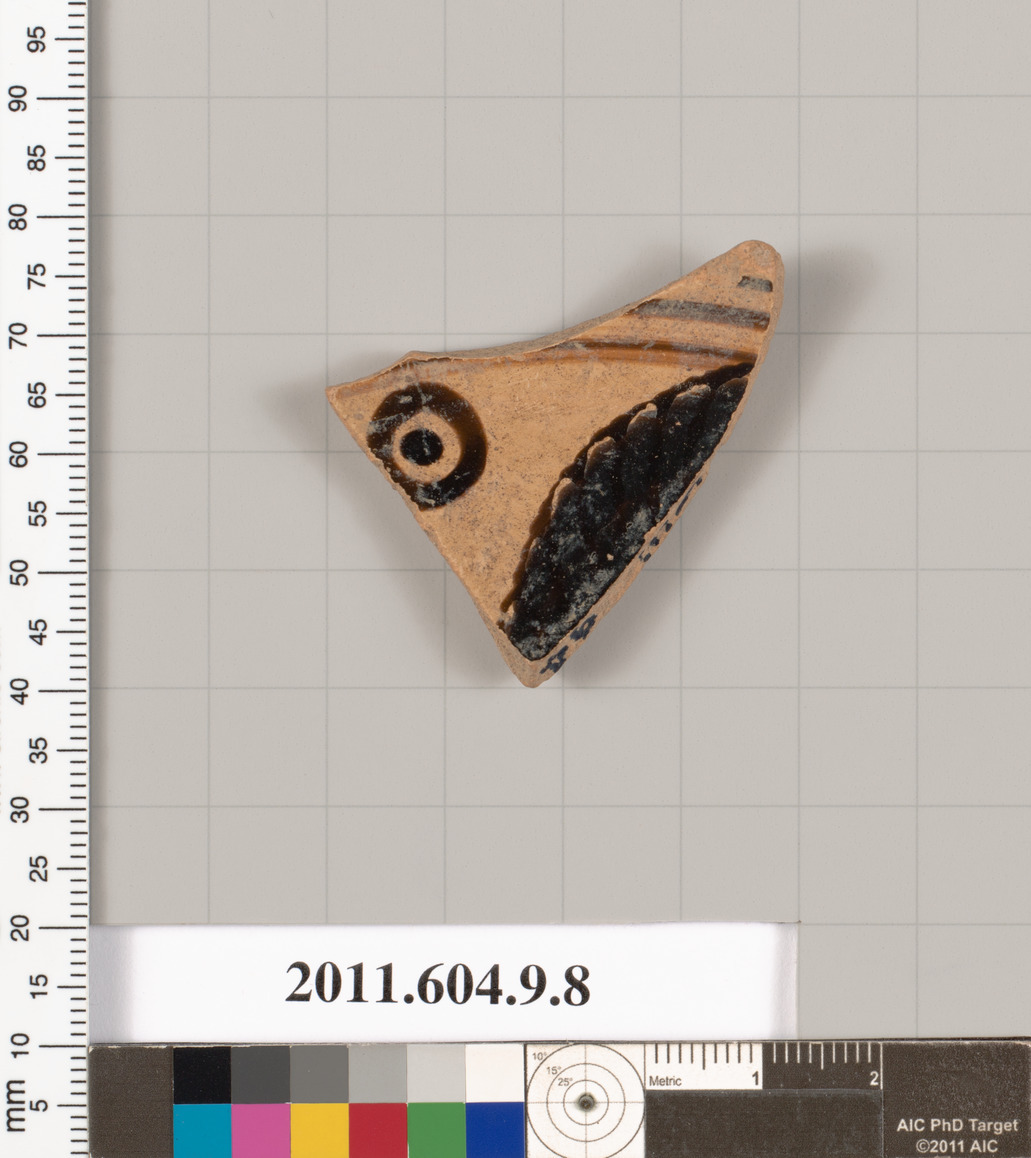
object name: kylix fragment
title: Terracotta fragment of a kylix (drinking cup)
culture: greek, laconian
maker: rider painter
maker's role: artist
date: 600-551 BCE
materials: terracotta